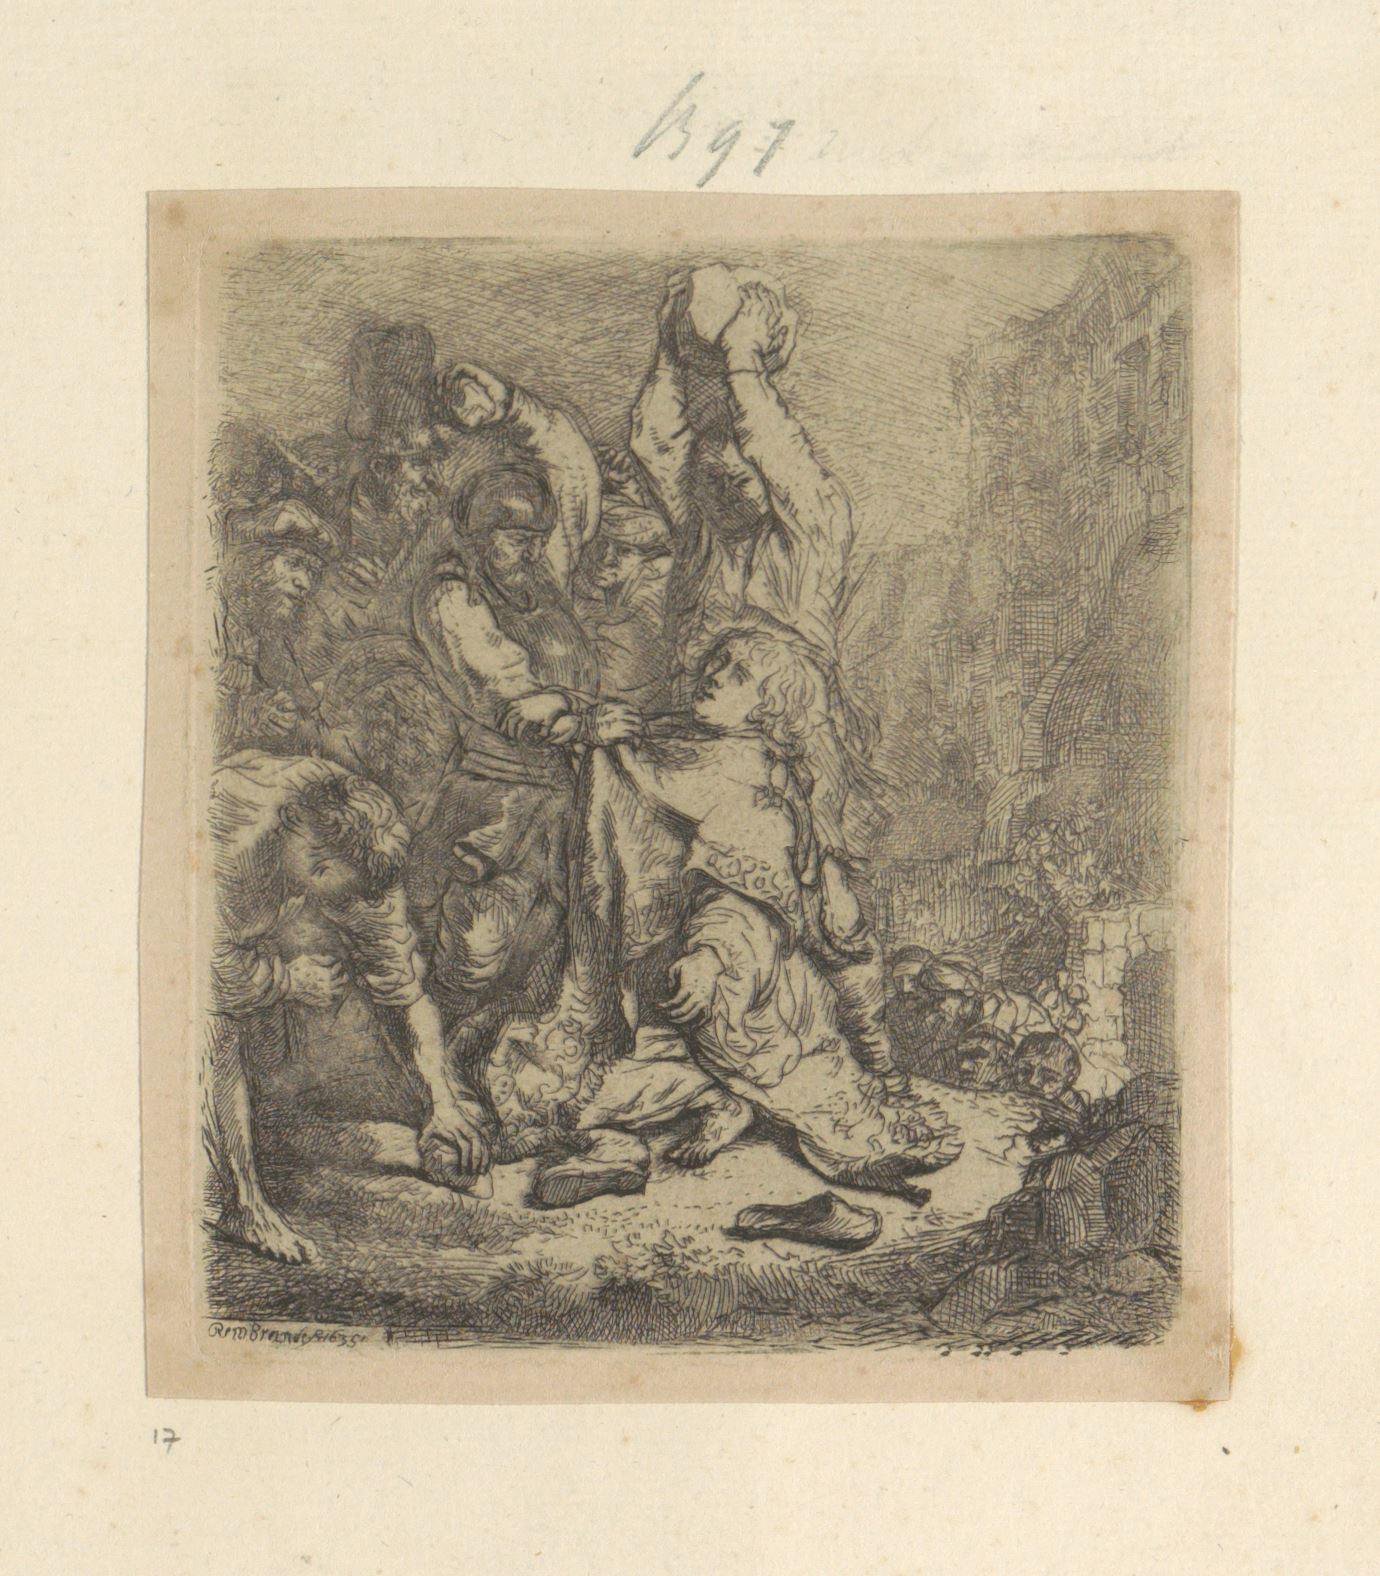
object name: album leaf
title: Steniging van Stefanus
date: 1635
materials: paper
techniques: etching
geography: paris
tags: life and acts of stephen (acts 6:8 - 8:2)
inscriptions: date